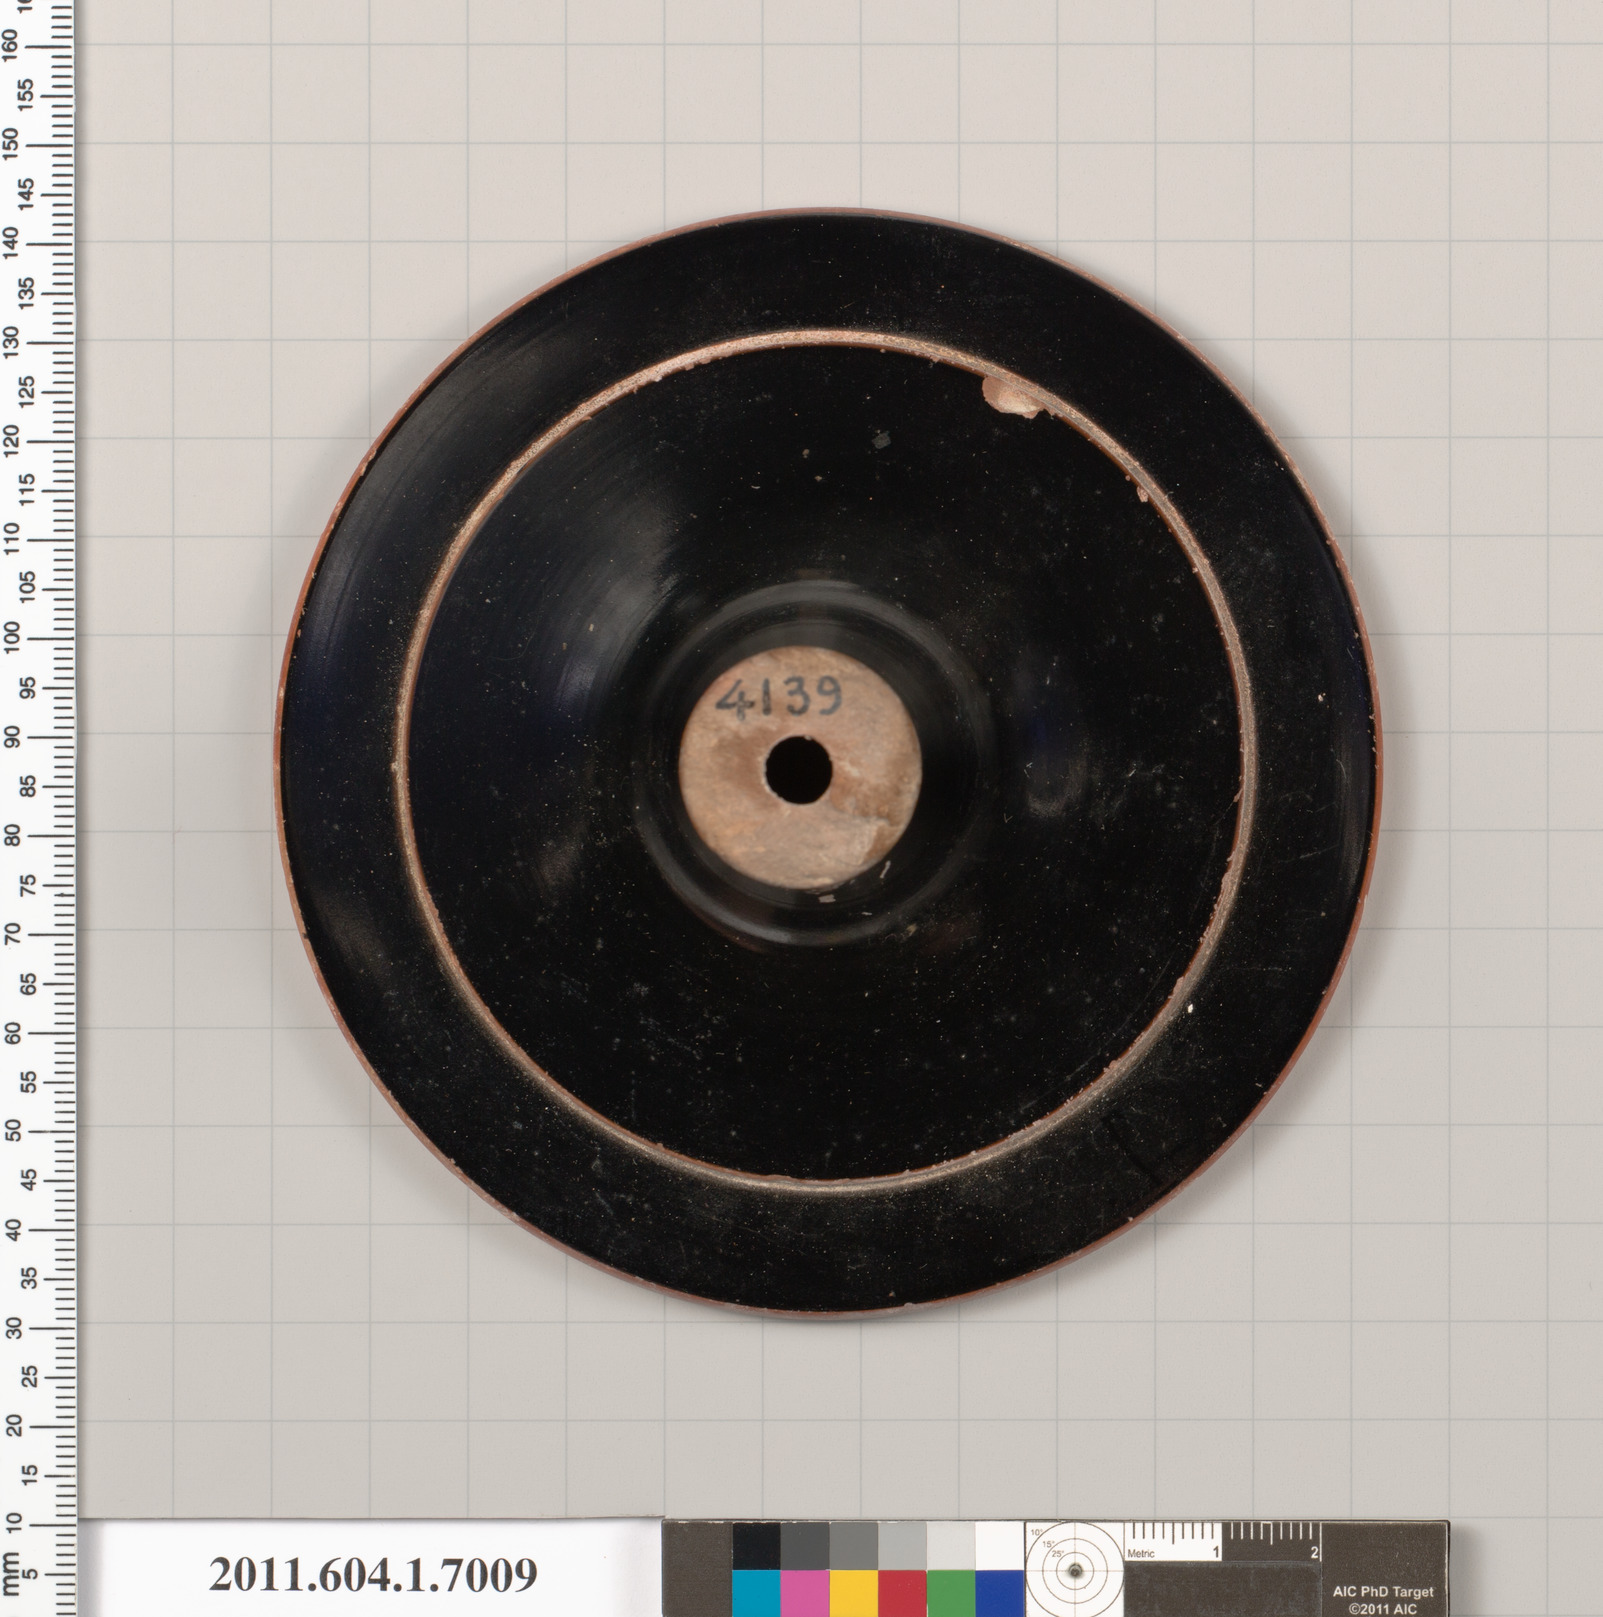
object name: kylix fragment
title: Terracotta fragment of a kylix (drinking cup)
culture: greek, attic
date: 500-490 BCE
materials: terracotta